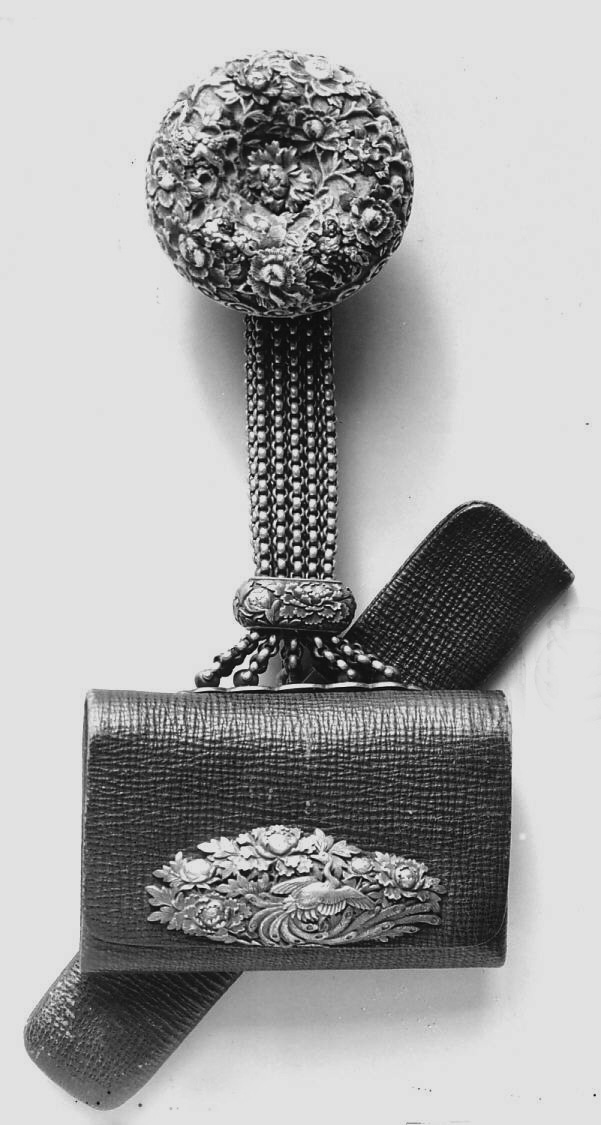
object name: tobacco set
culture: japanese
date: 1701-1900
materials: ivory, leather, silver